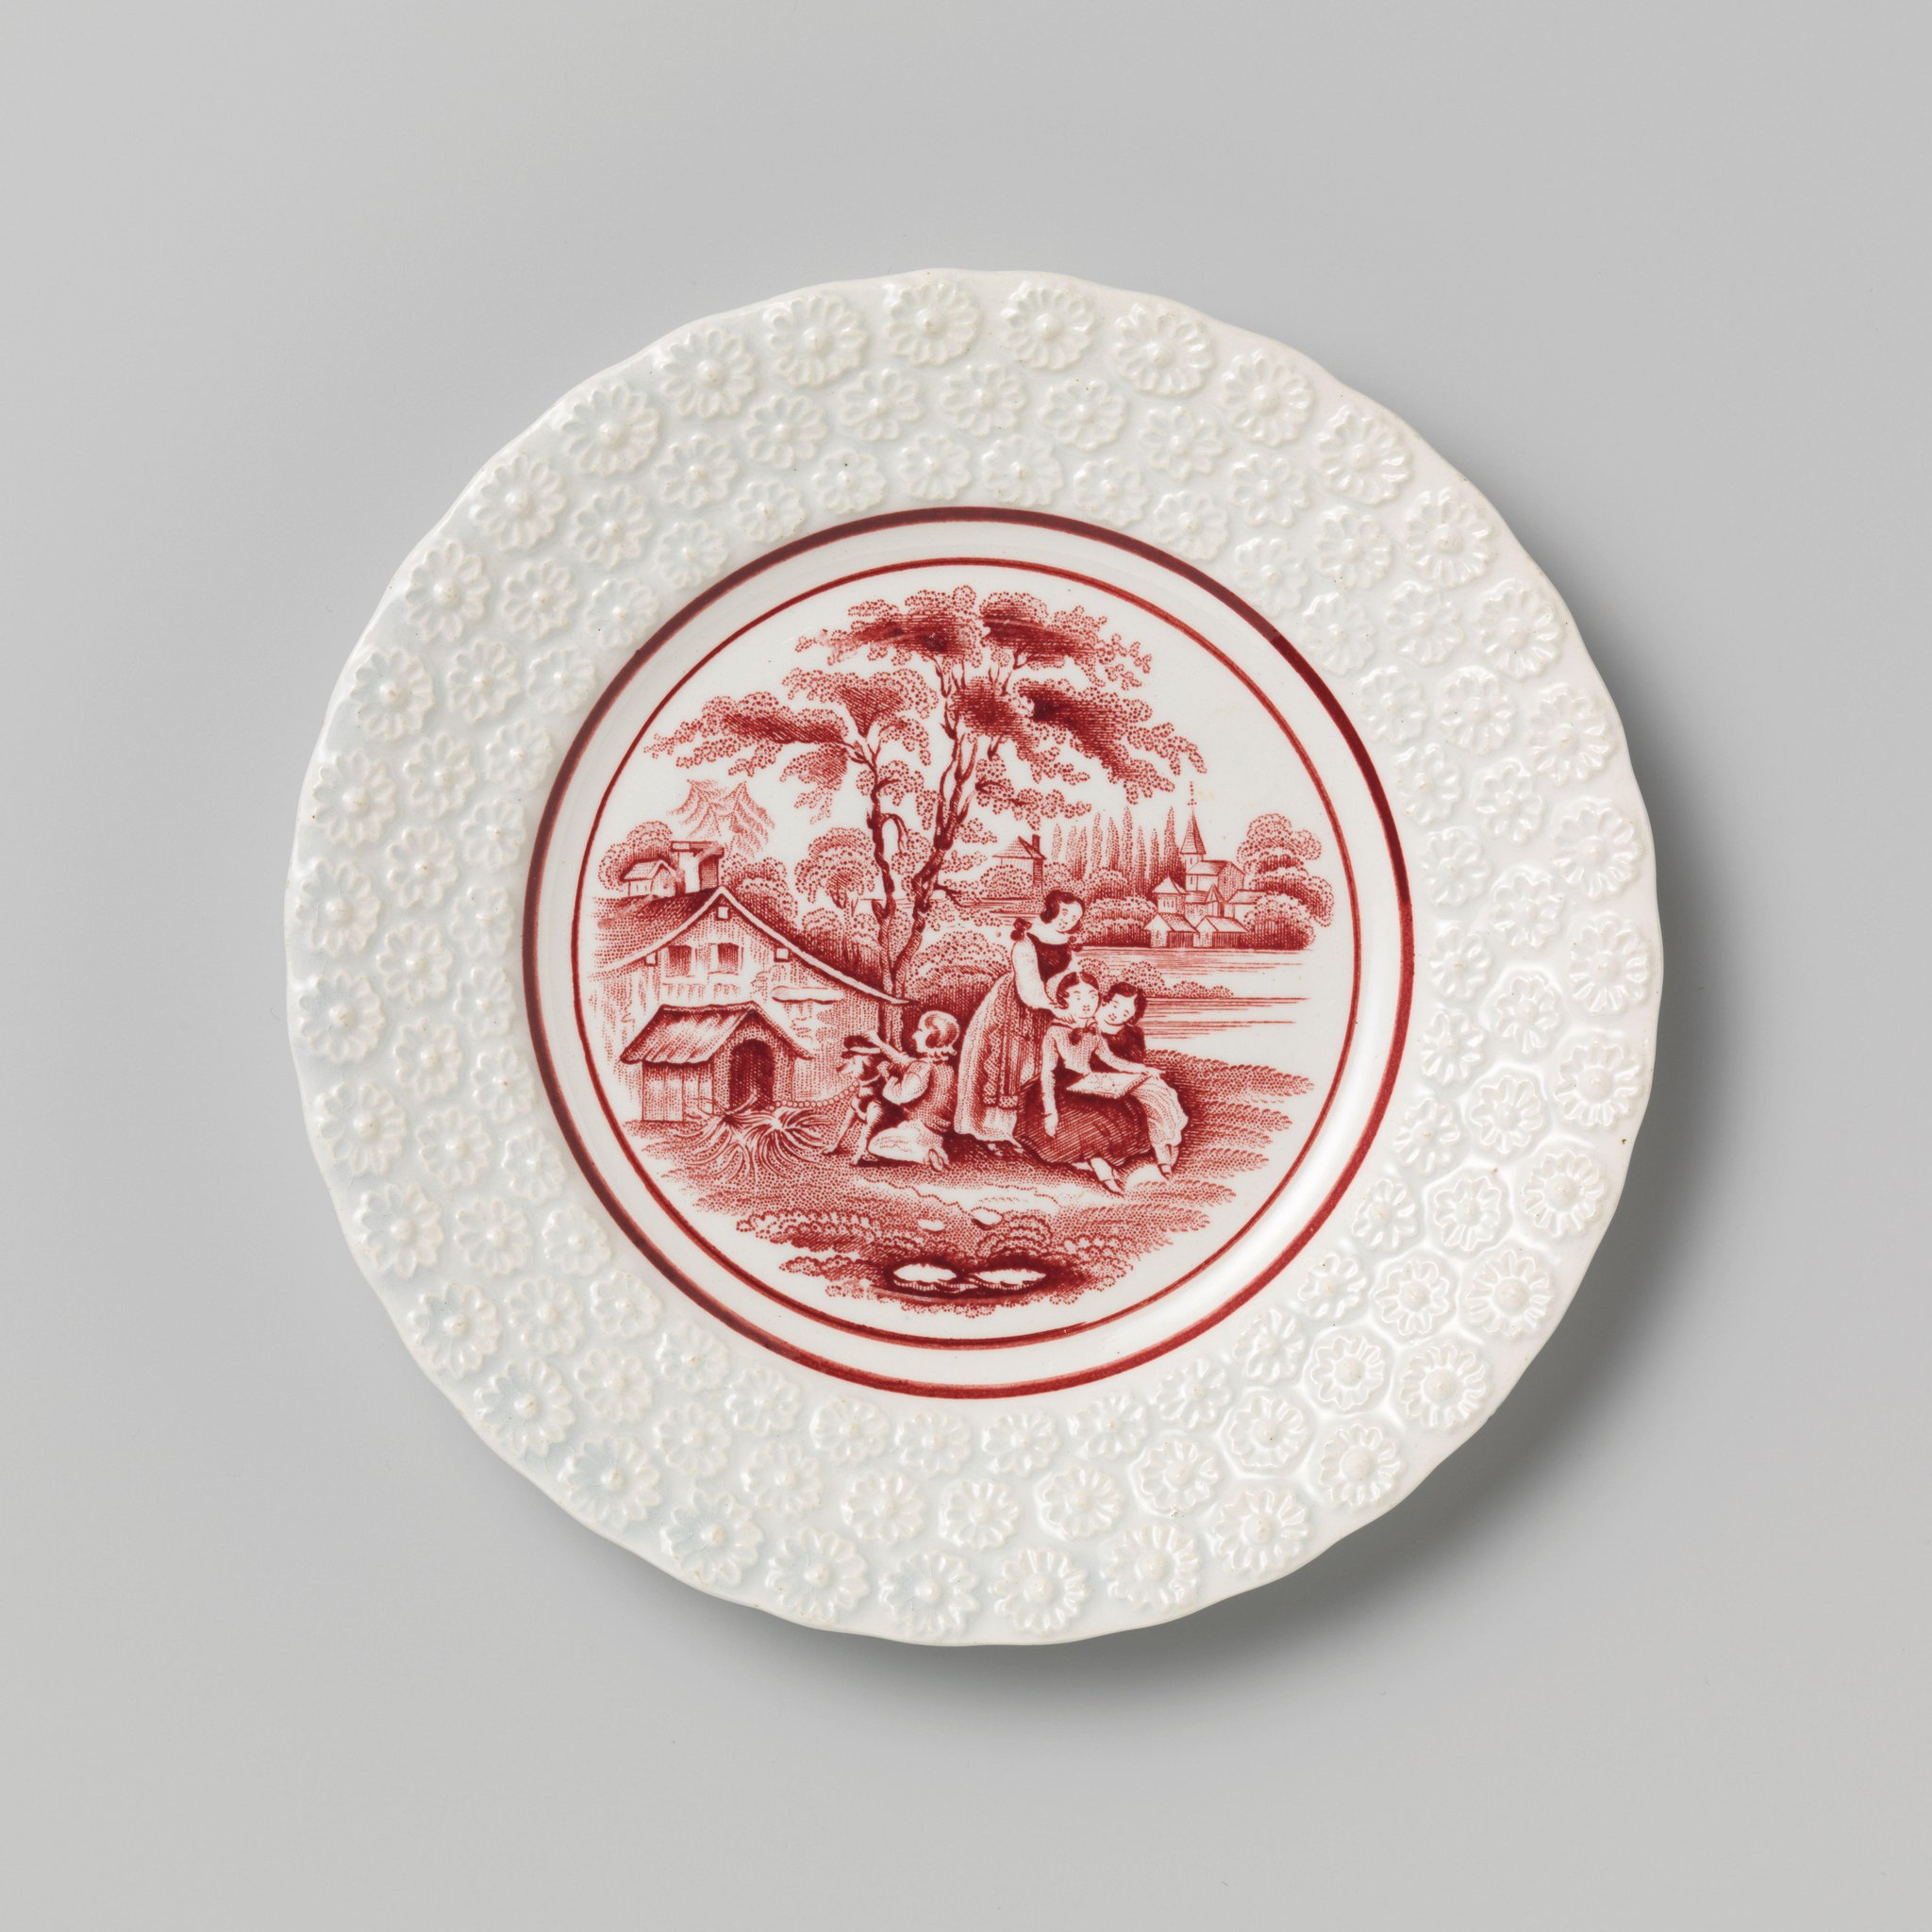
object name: plate dish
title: Bord met een gezelschap met hond in een landschap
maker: petrus regout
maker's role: plateelbakker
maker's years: 1801-1879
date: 1850-1875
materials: creamware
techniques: transfer decoration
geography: maastricht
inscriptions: check stamp: ‘PR // 15’, mark: ‘YOUNG ARTISTS // PR’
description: Bord van aardewerk met rood transferdecor, rond, het plat versierd met een gezelschap met hond in een landschap. Om de voorstelling twee rode biezen. De rand met een bloemendecor in reliëf.